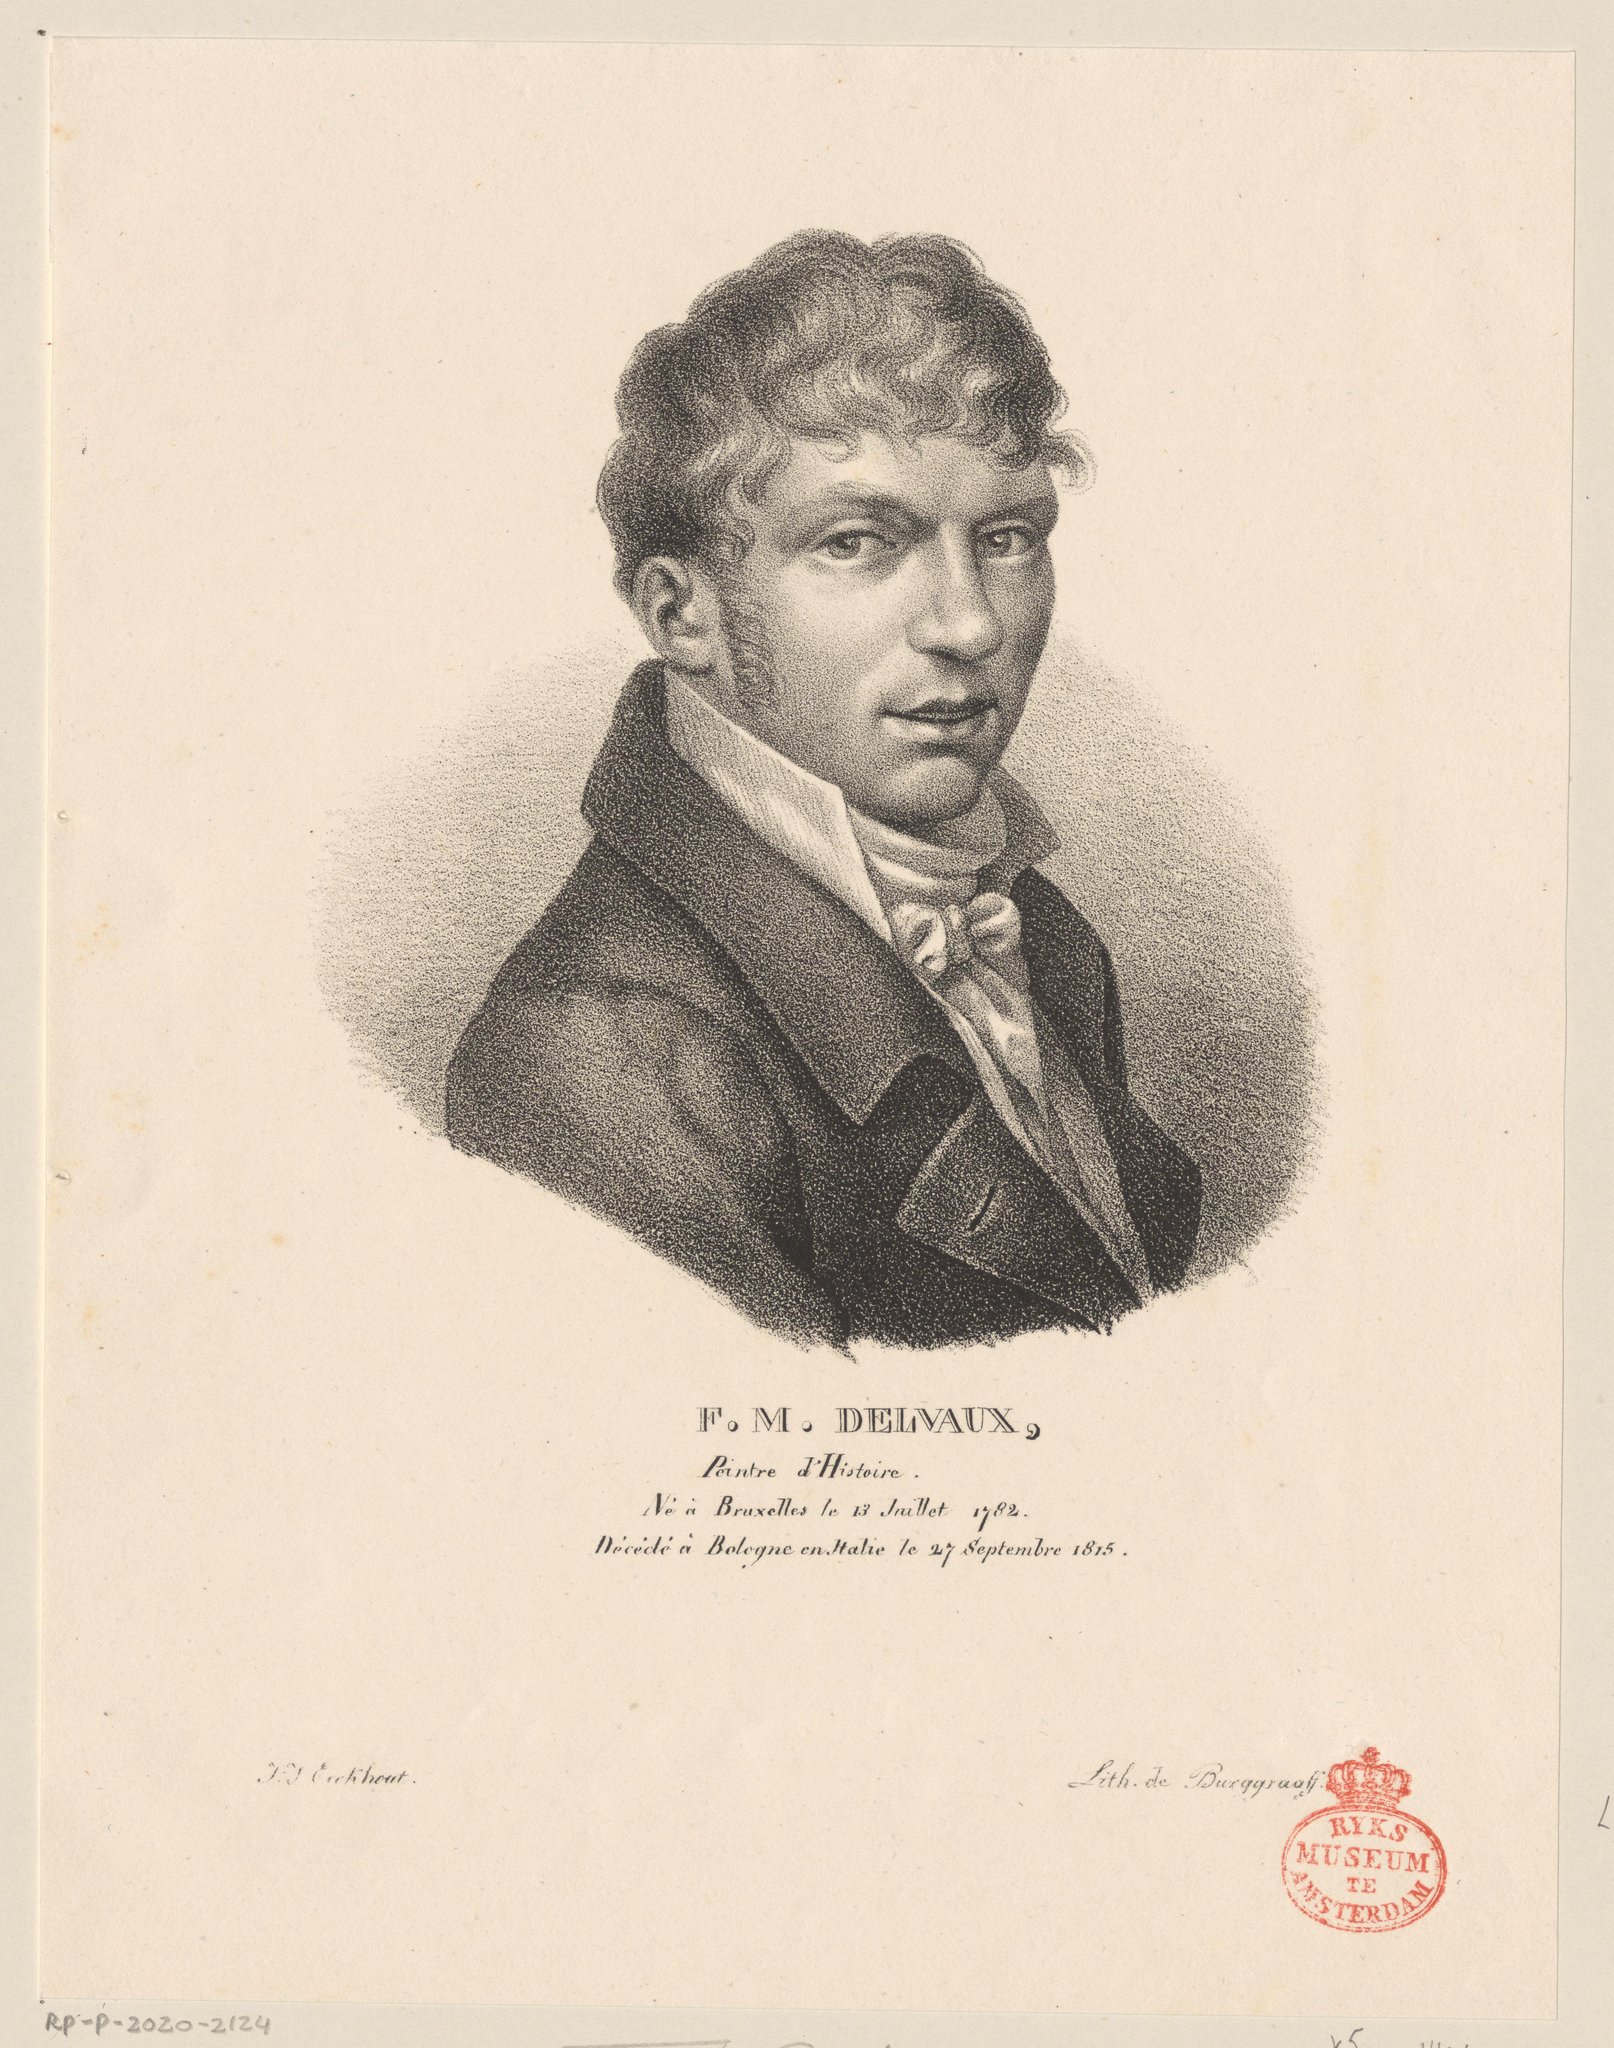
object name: print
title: Portret van Ferdinand Marie Delvaux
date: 1815-1861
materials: paper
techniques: lithograph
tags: brussels, artist, historical persons, portrait, self-portrait of painter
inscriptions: collector's mark: Lugt 12